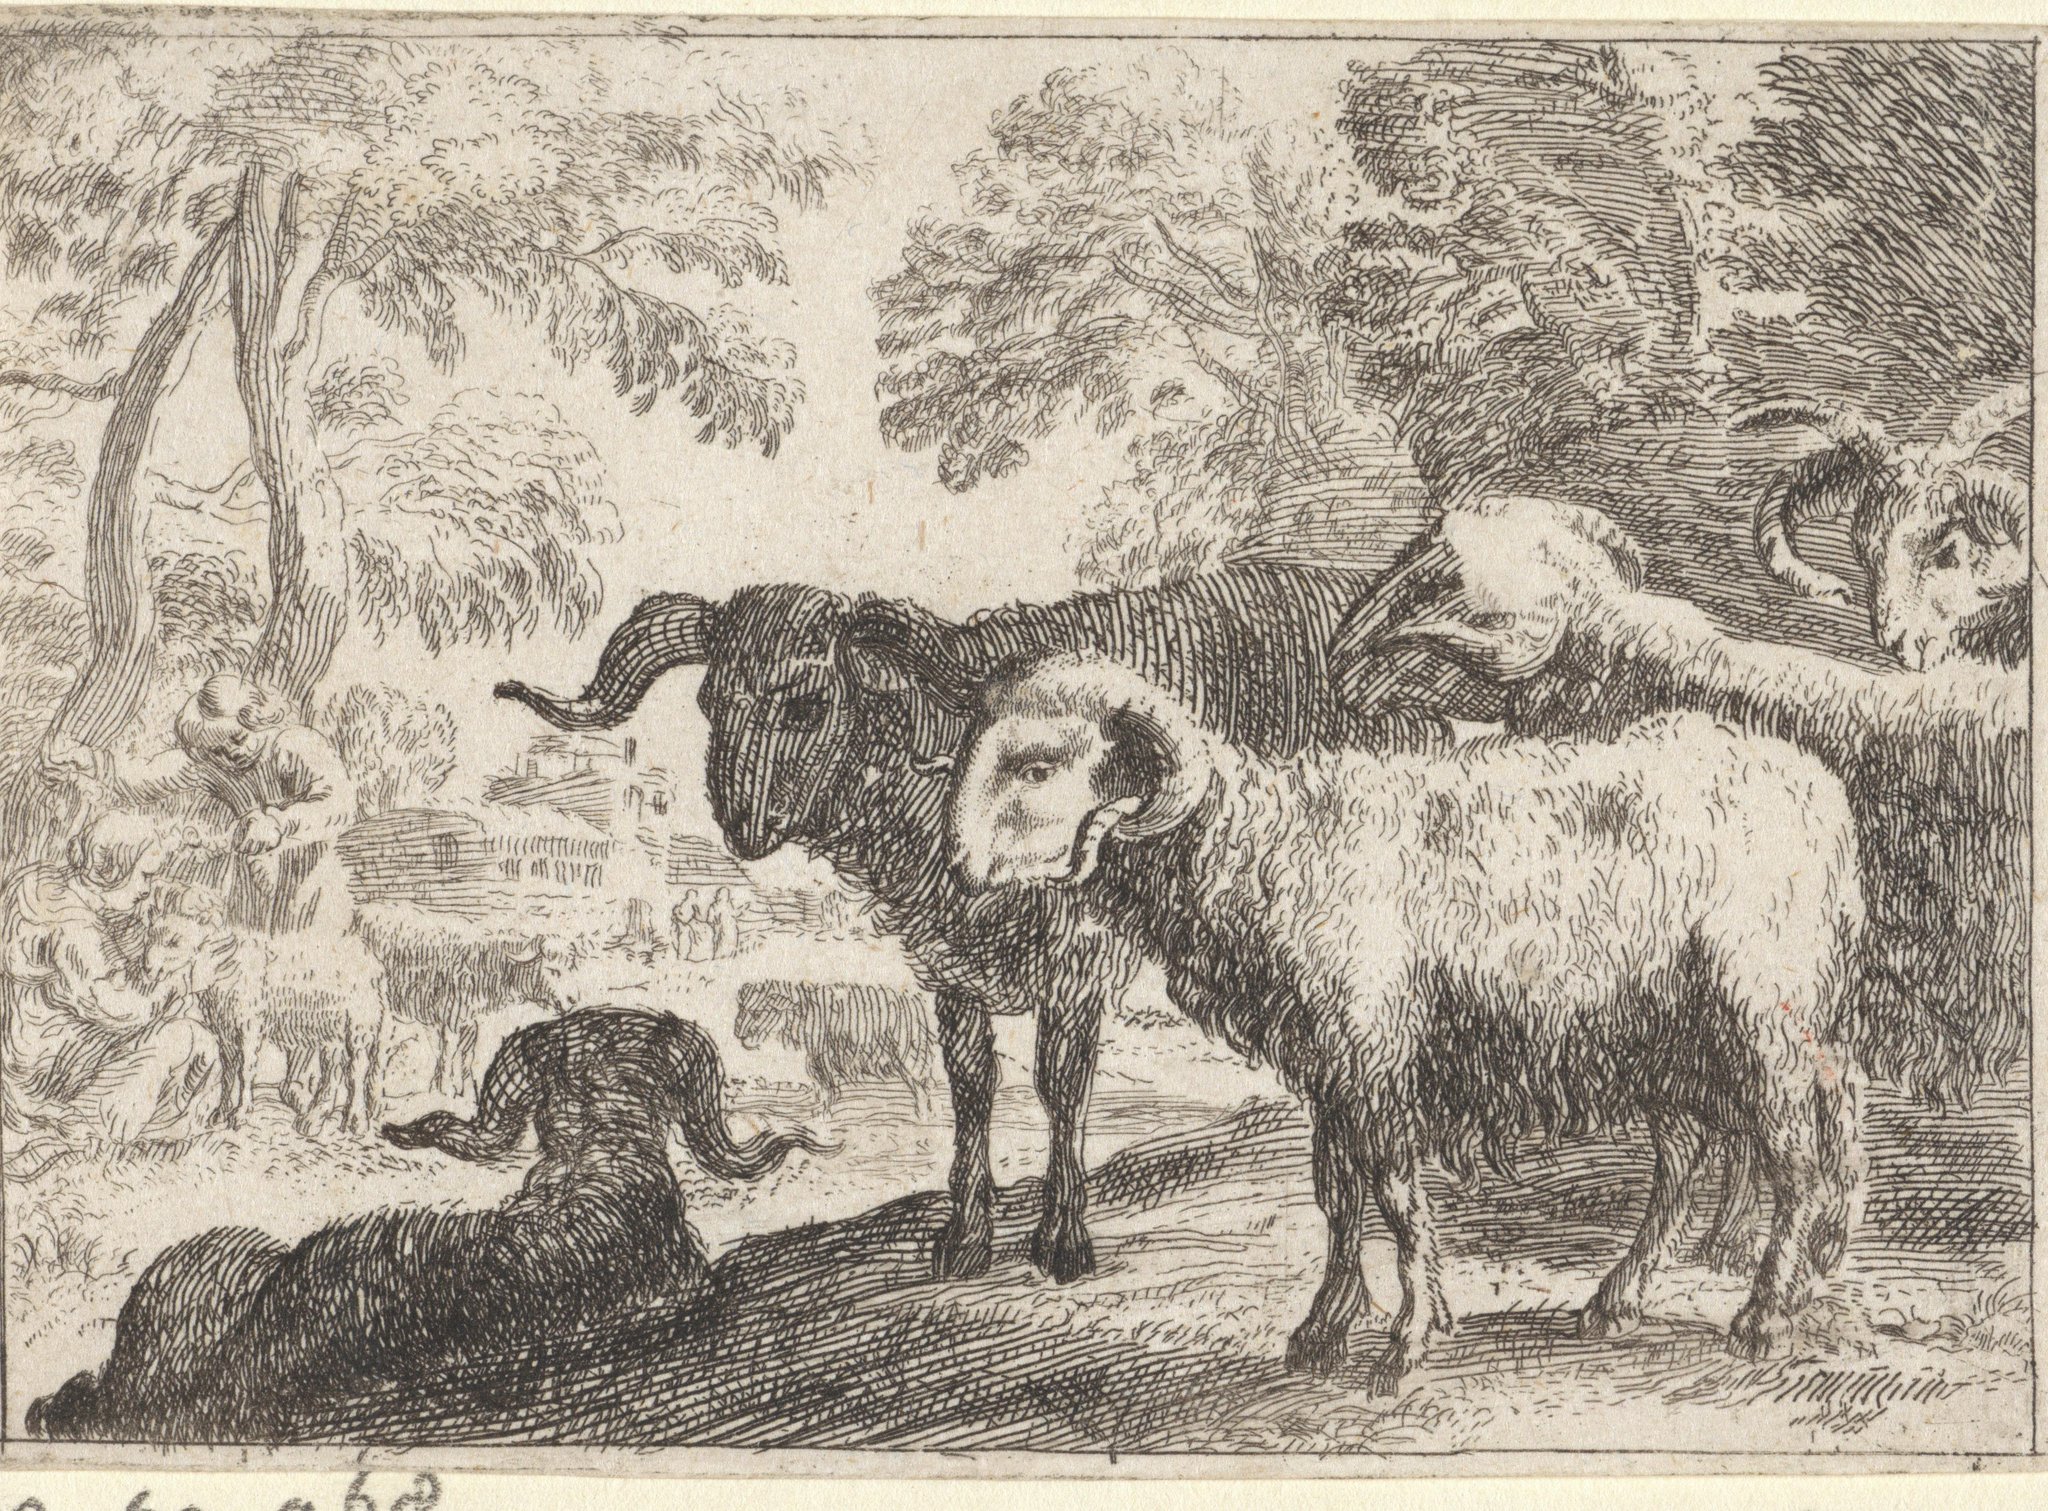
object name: print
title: Rammen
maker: Anonymous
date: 1636-1705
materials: paper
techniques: etching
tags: solomon expels abiathar from the priesthood and banishes him to anathoth, landscapes, ram, rural housing, e.g. country-house, villa, cottage, herd, flock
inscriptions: collector's mark: Lugt 240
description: Achter vijf rammen zijn een herder en herderin met een kudde schapen te zien. In de verte ligt een gebouw.